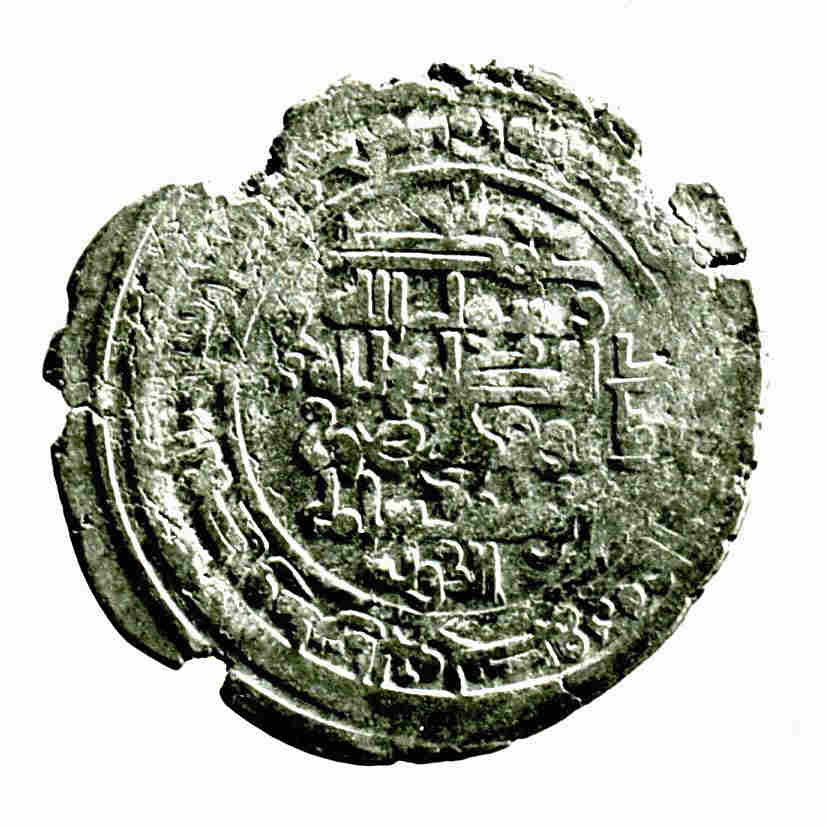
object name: coin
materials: silver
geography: iran